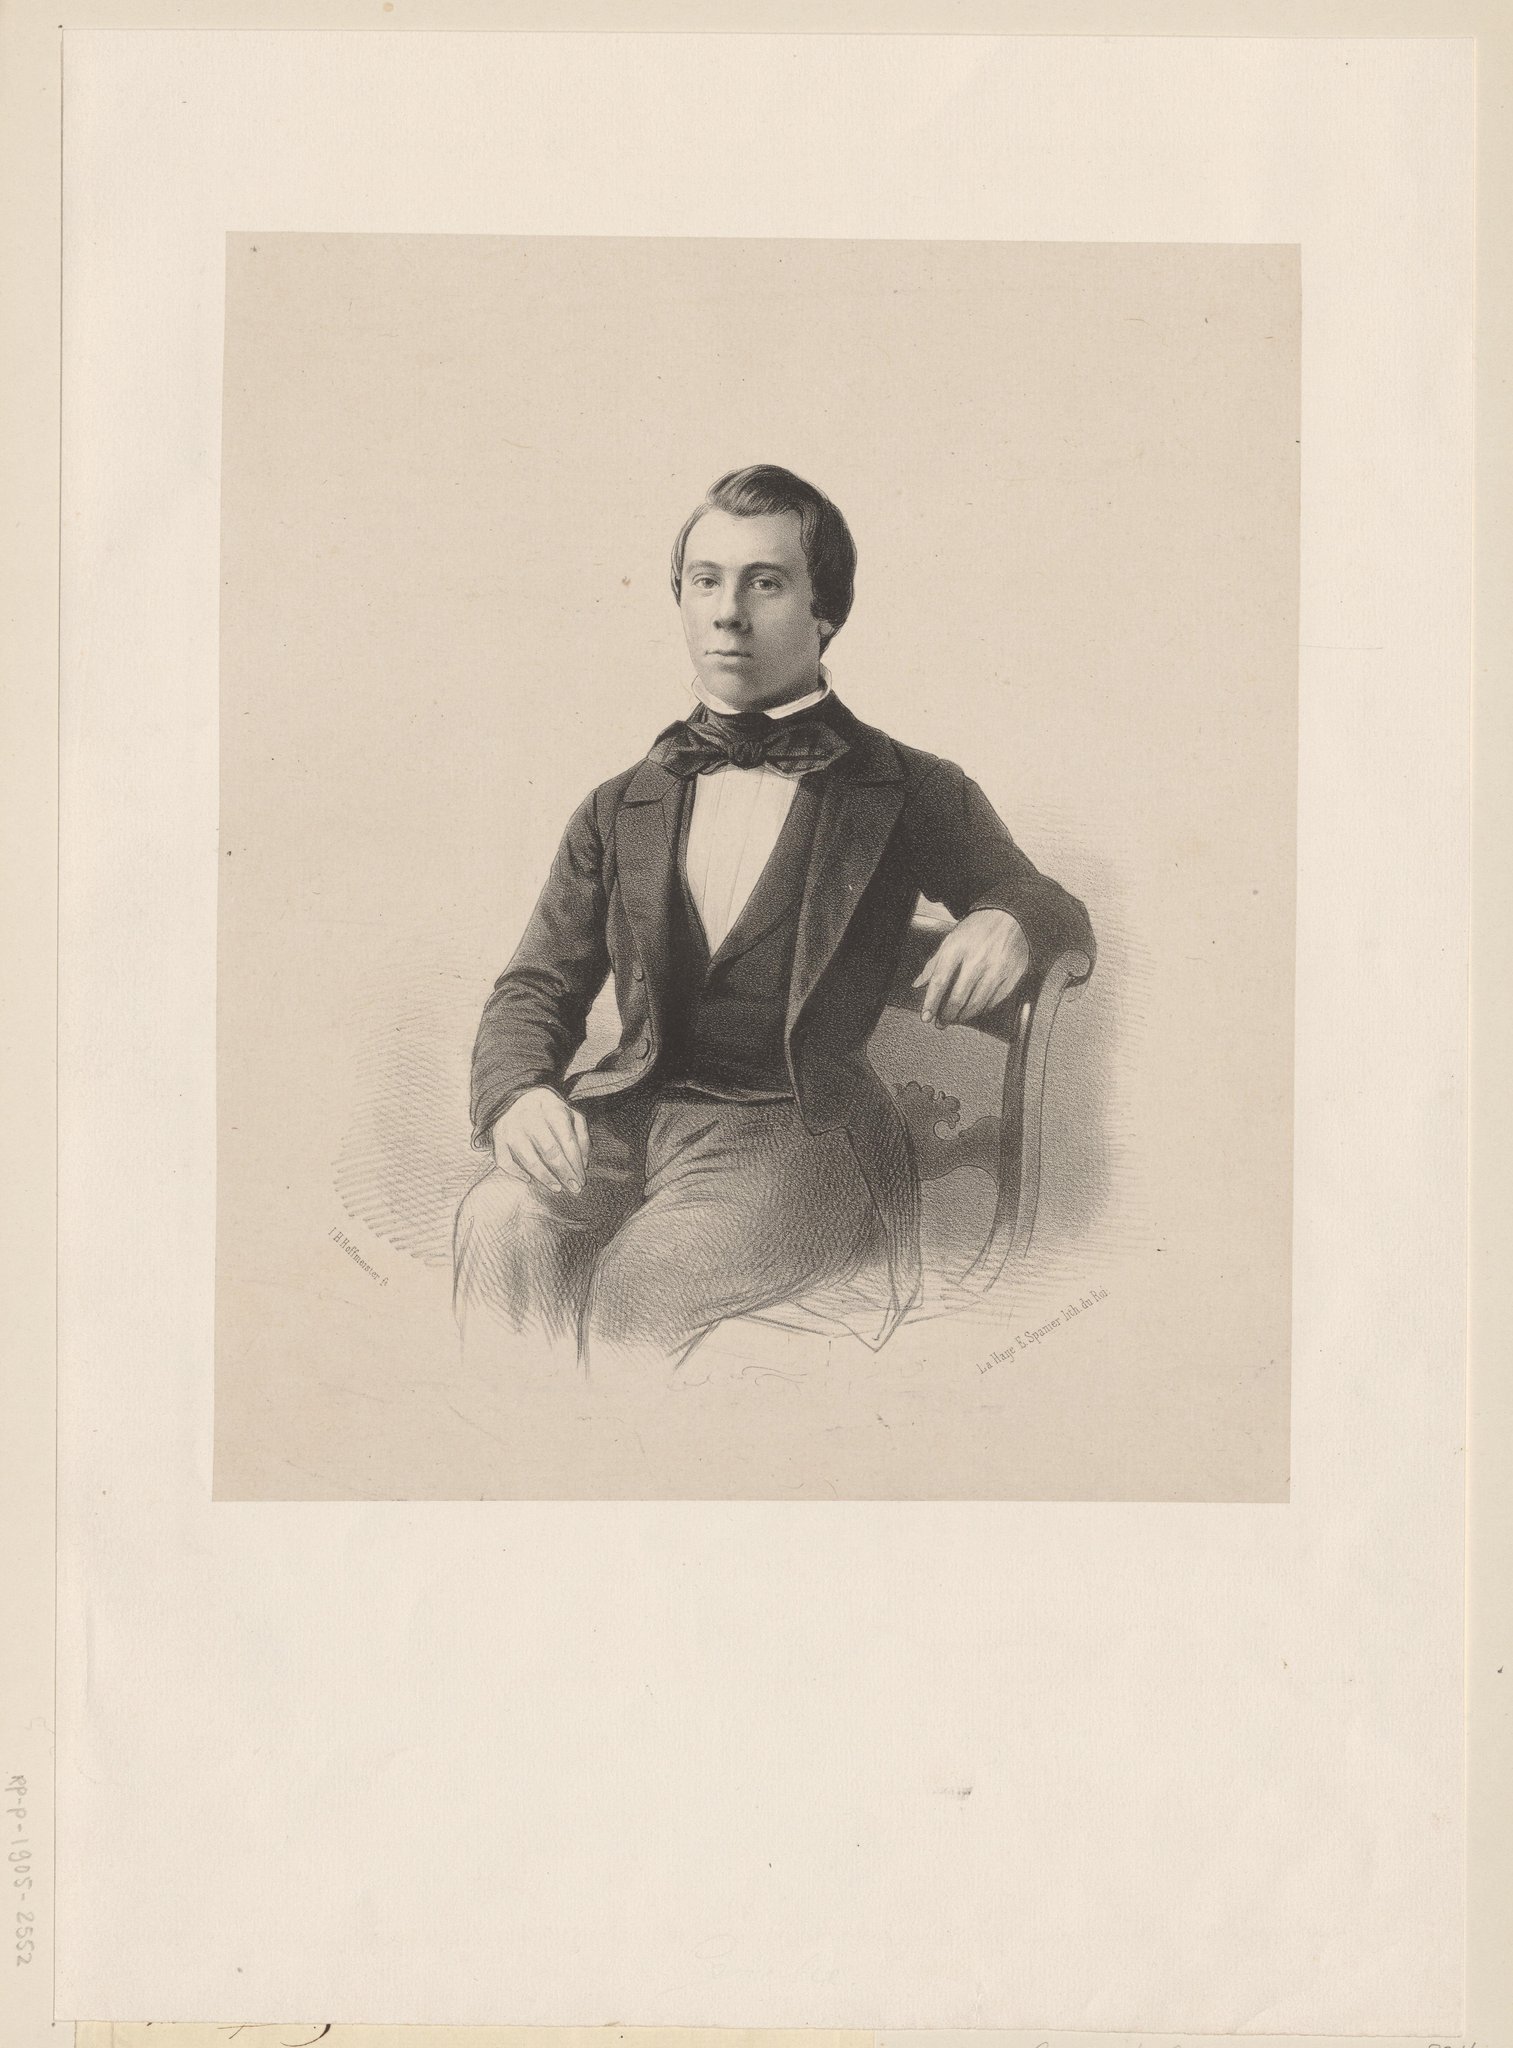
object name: print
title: Portret van een onbekende man, mogelijk Auguste Gericke of J.F.C. Gericke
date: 1851-1883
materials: paper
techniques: lithograph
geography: the hague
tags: historical persons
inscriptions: collector's mark: Lugt 2228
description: Handgeschreven tekst in het Nederlands over Auguste Gericke op een los blad geplakt op opzetvel.